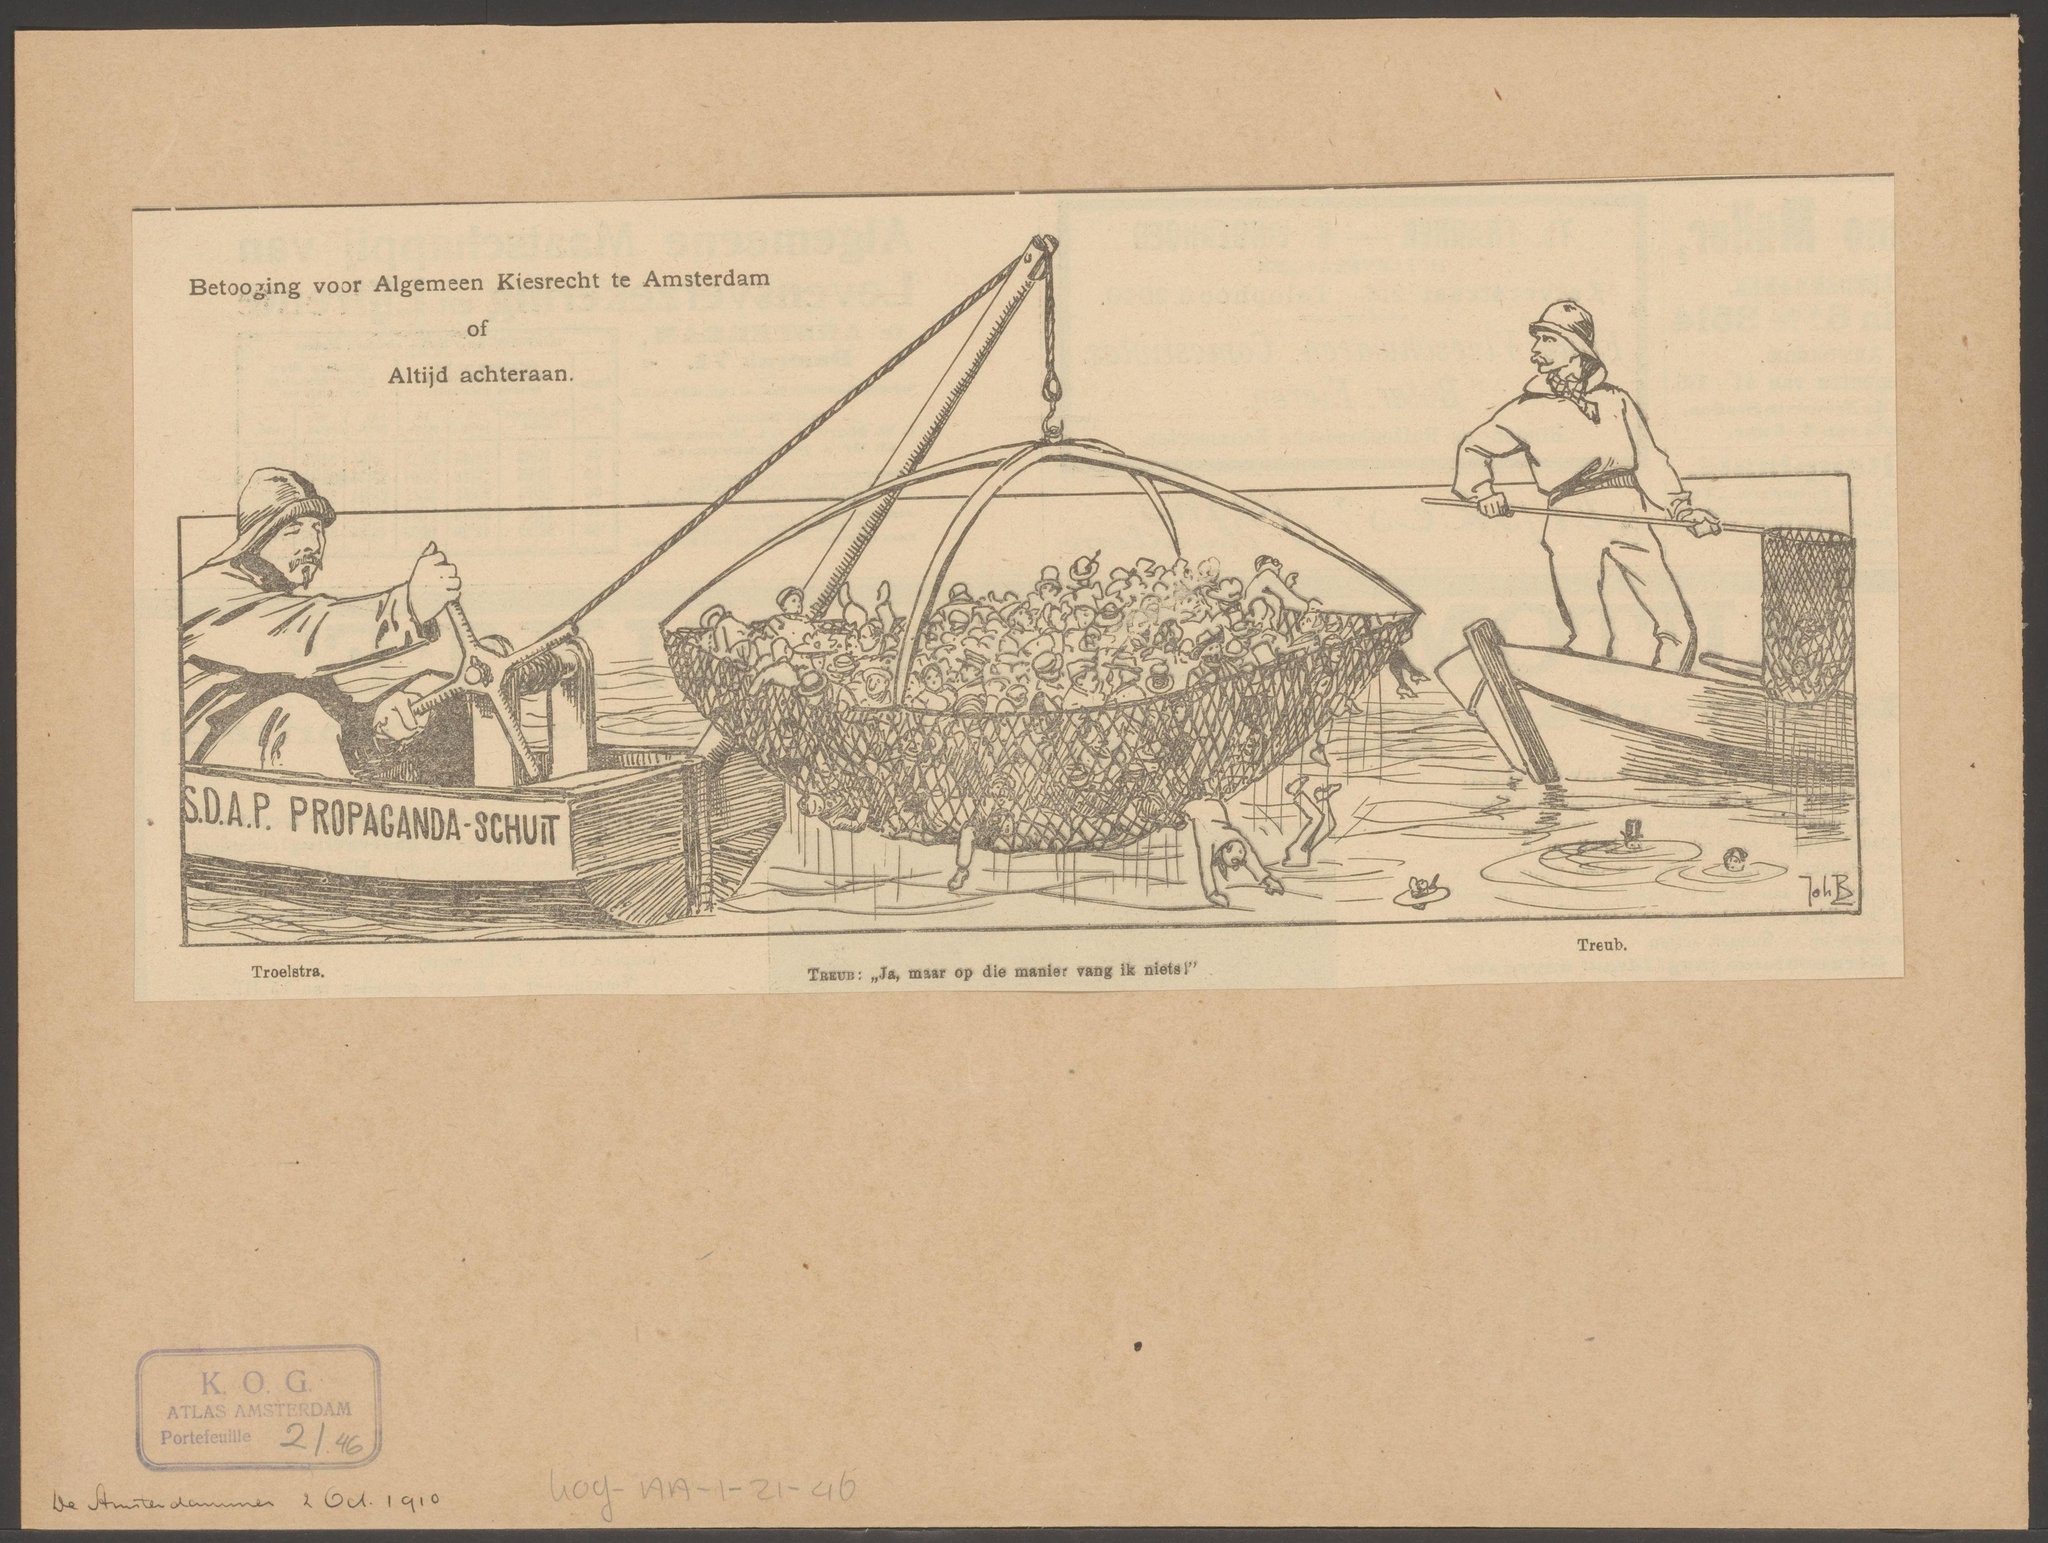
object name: photomechanical print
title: Betooging voor Algemeen Kiesrecht te Amsterdam of Altijd achteraan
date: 1910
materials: paper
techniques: letterpress printing, line block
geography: netherlands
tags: voorschoten, the hague, politician, fishing net, politician, e.g. party leader, fisherman, political caricatures and satires, amsterdam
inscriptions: date: ‘De Amsterdammer 2 Oct. 1910’, collector's mark: Lugt 1641b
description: Onderwerpsrubriek binnen de Atlas Amsterdam: Kiesverenigingen, Politieke partijen.